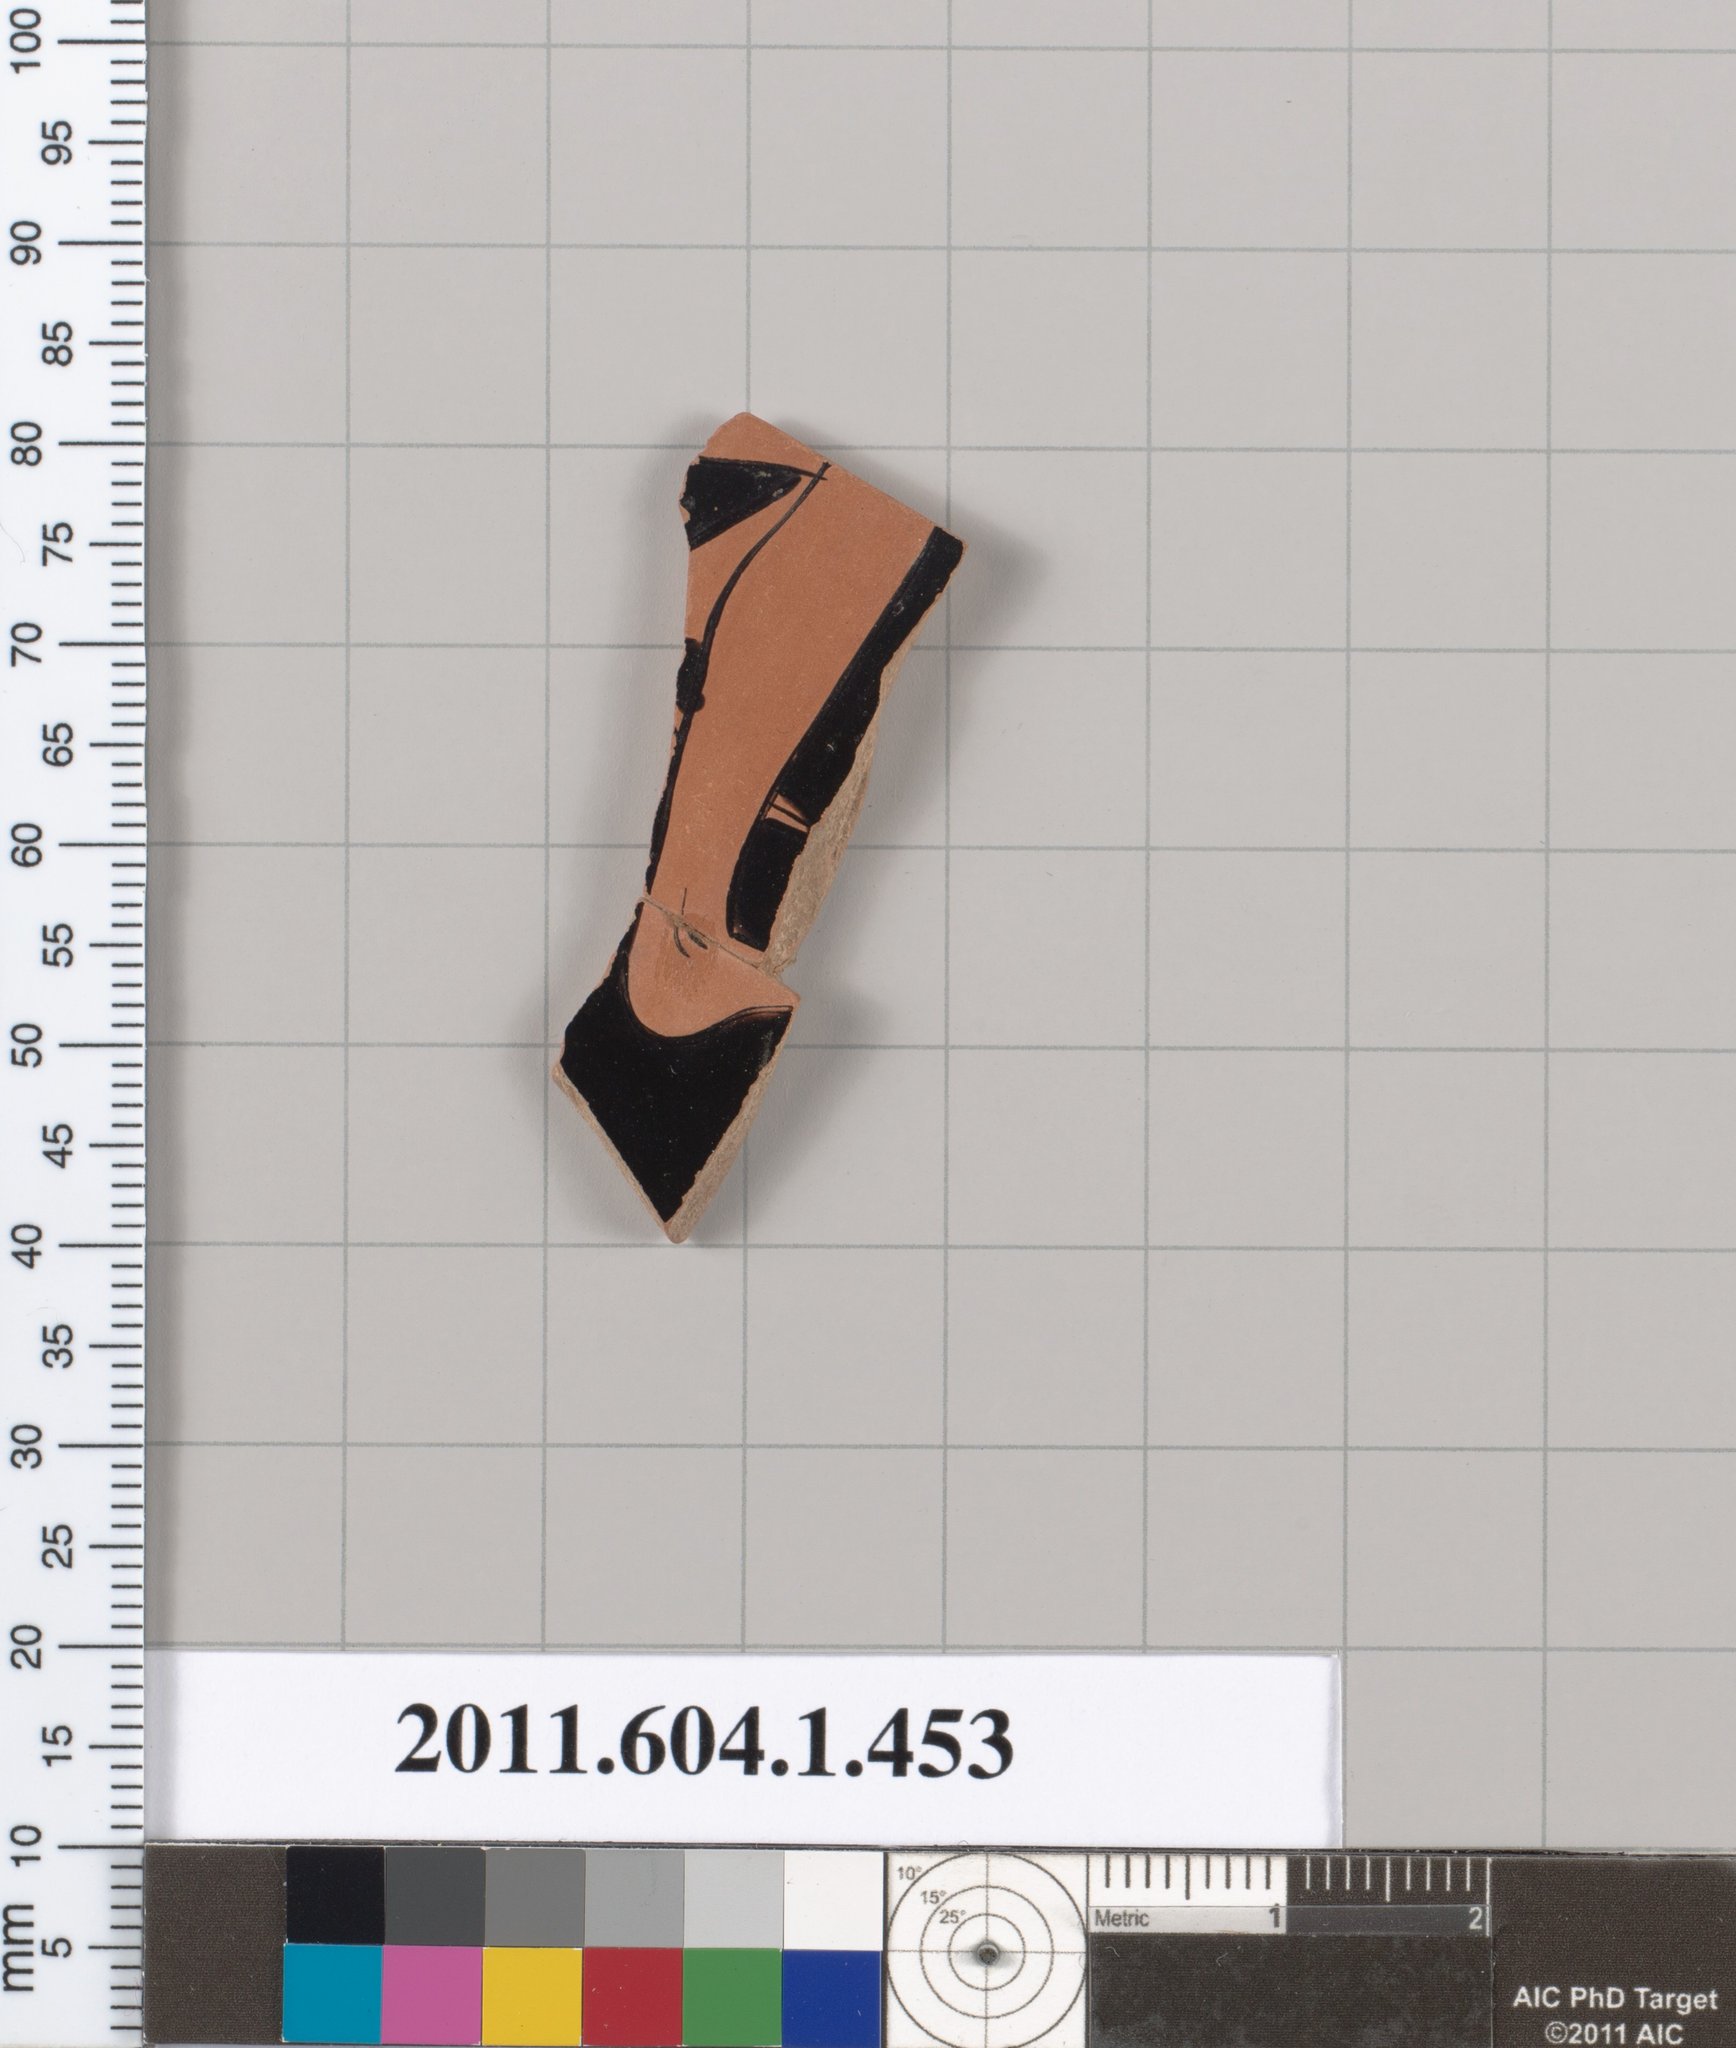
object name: kylix fragment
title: Terracotta fragment of a kylix (drinking cup)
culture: greek, attic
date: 475-451 BCE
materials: terracotta